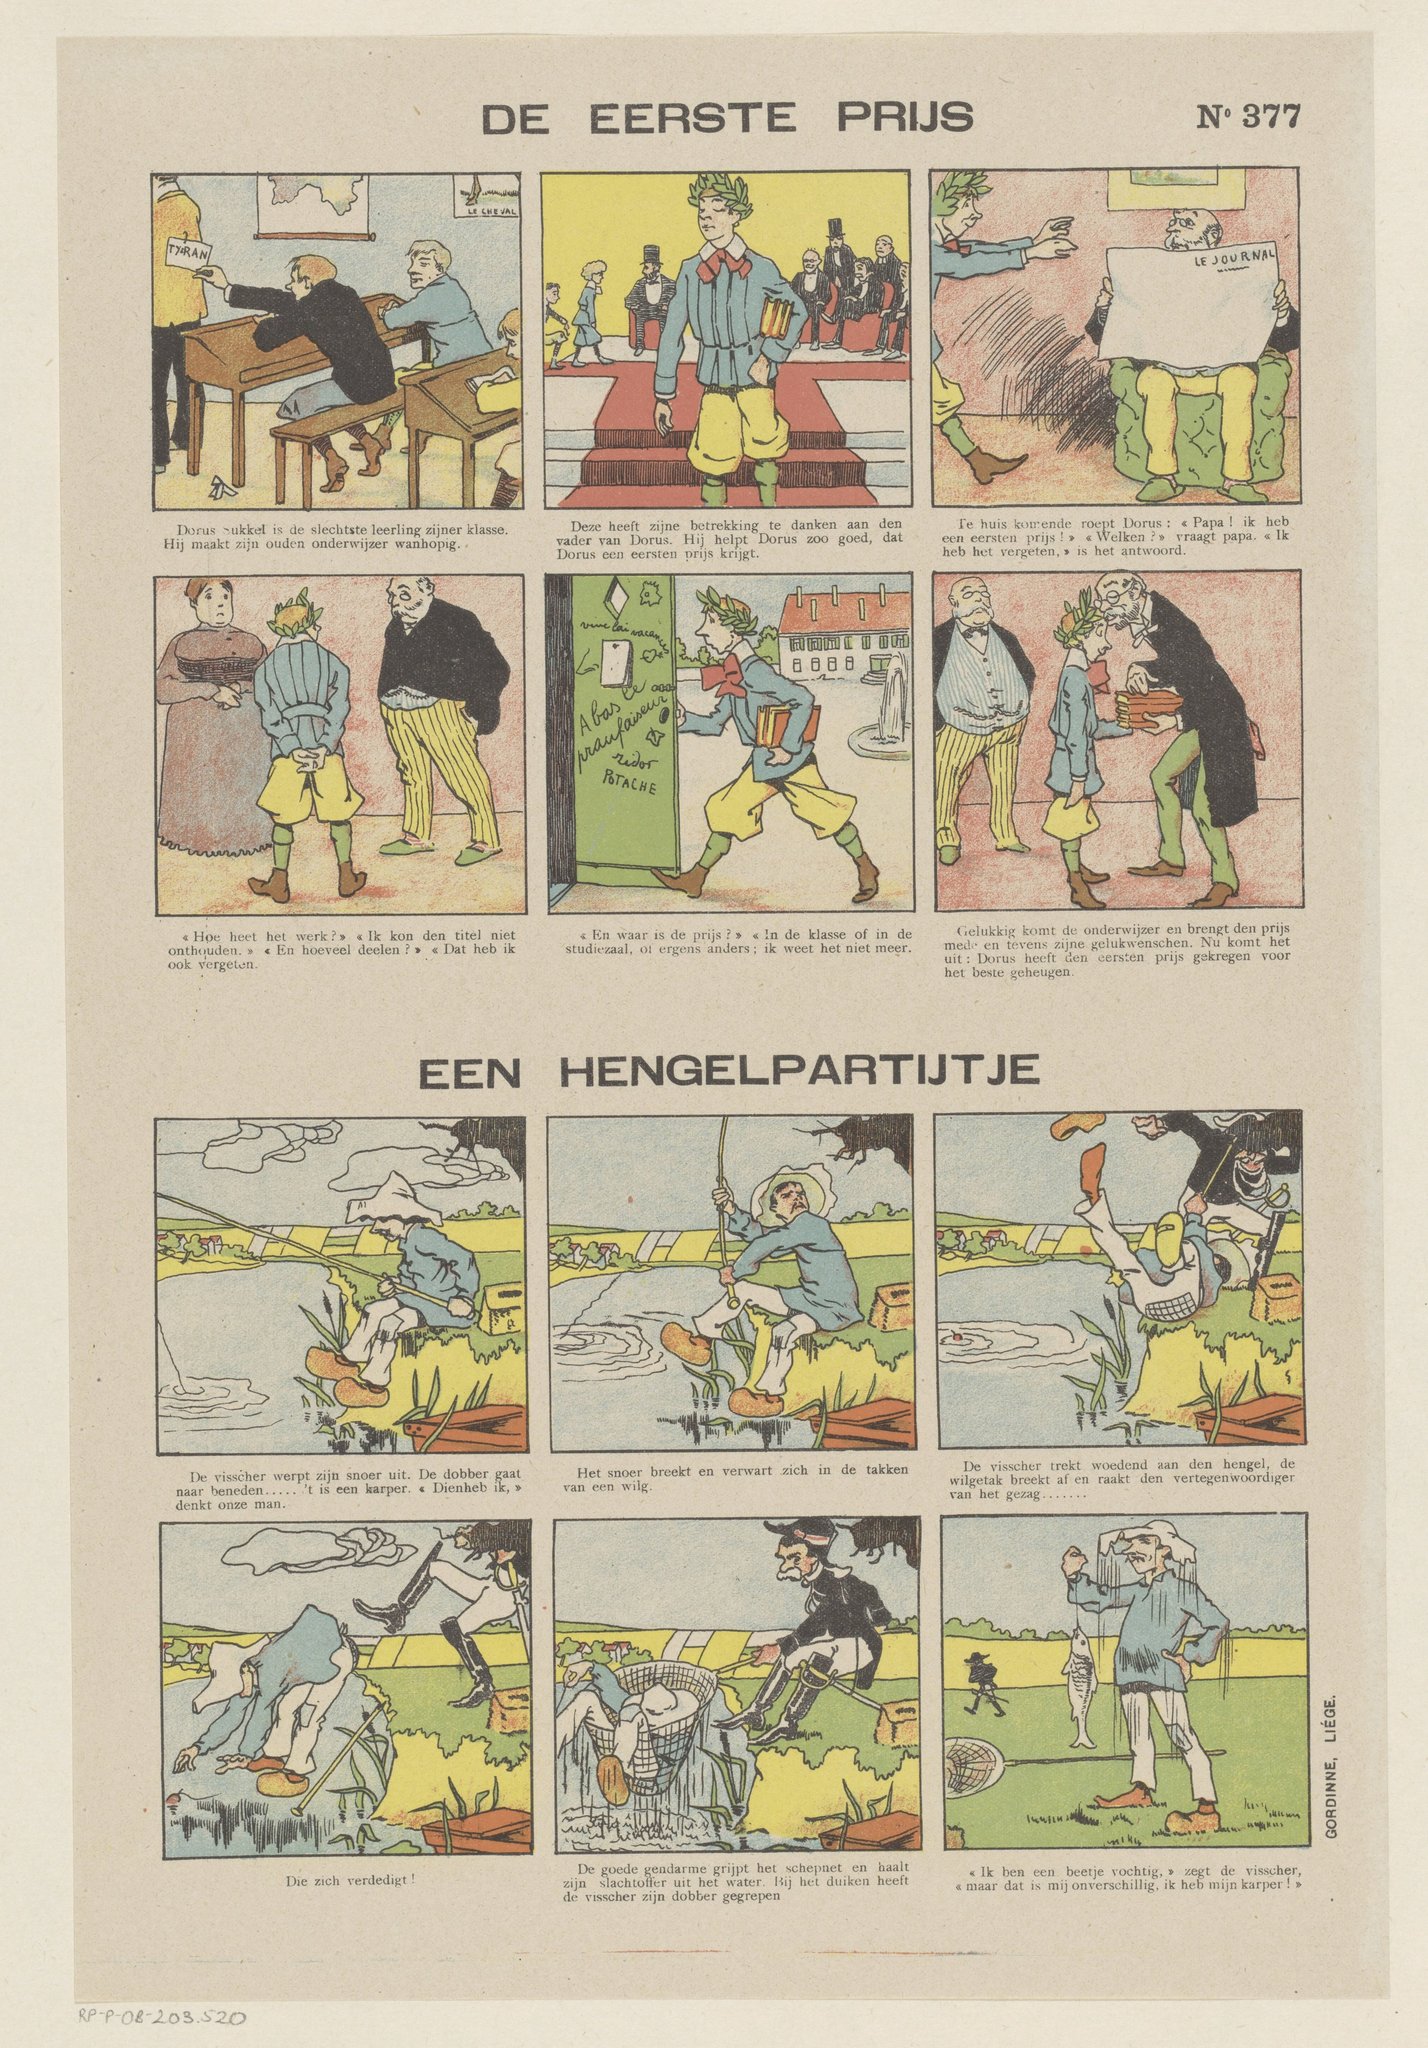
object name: popular print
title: De eerste prijs / Een hengelpartijtje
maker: Anonymous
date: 1894-1959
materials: paper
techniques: lithograph, letterpress printing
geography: liège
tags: education, science and learning, bad behaviour, fishing (sports)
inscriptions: collector's mark: Lugt 2760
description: Blad met 12 voorstellingen. Boven zes voorstellingen over de slechte leerling Dorus Sukkel die een prijs wint. Onder zes voorstellingen over een visser die per ongeluk een karper vangt. Onder elke afbeelding een onderschrift. Genummerd rechtsboven: No 377.